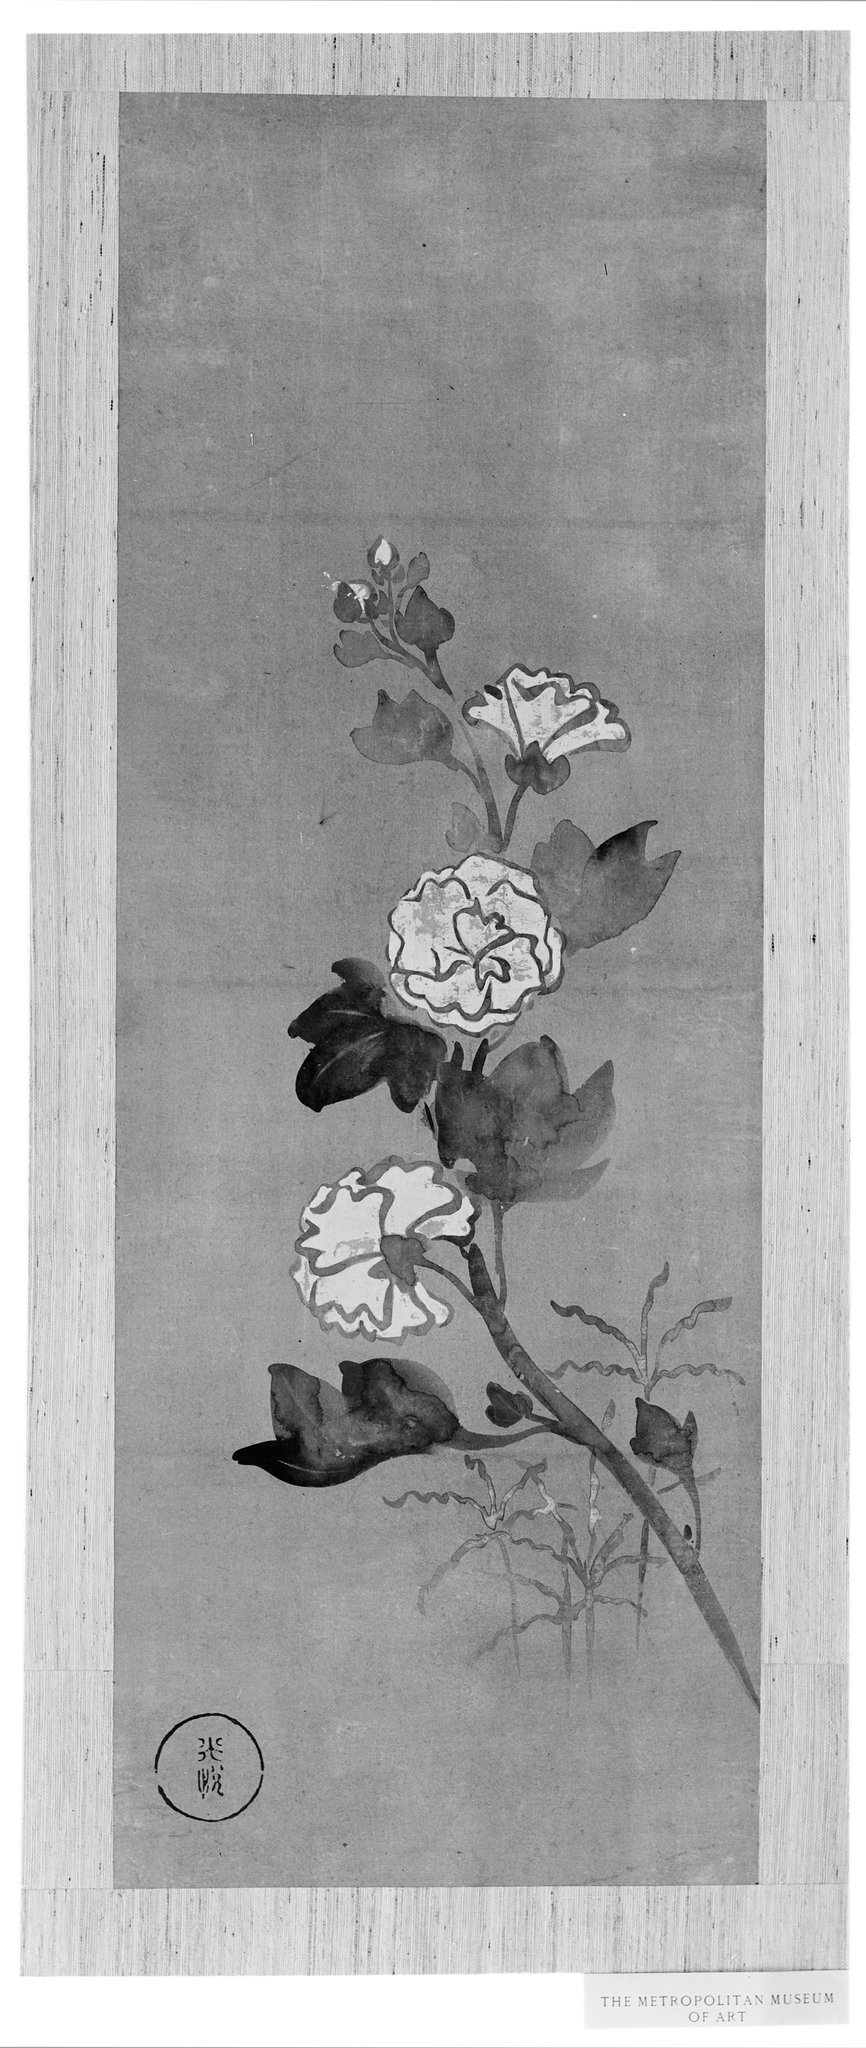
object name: painting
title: Rabbits under the Moon, Peonies, and Hollyhocks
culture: japanese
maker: ogata kōrin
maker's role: artist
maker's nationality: japanese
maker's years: 1658-1716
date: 1801-1900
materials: ink, paper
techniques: painting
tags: flowers